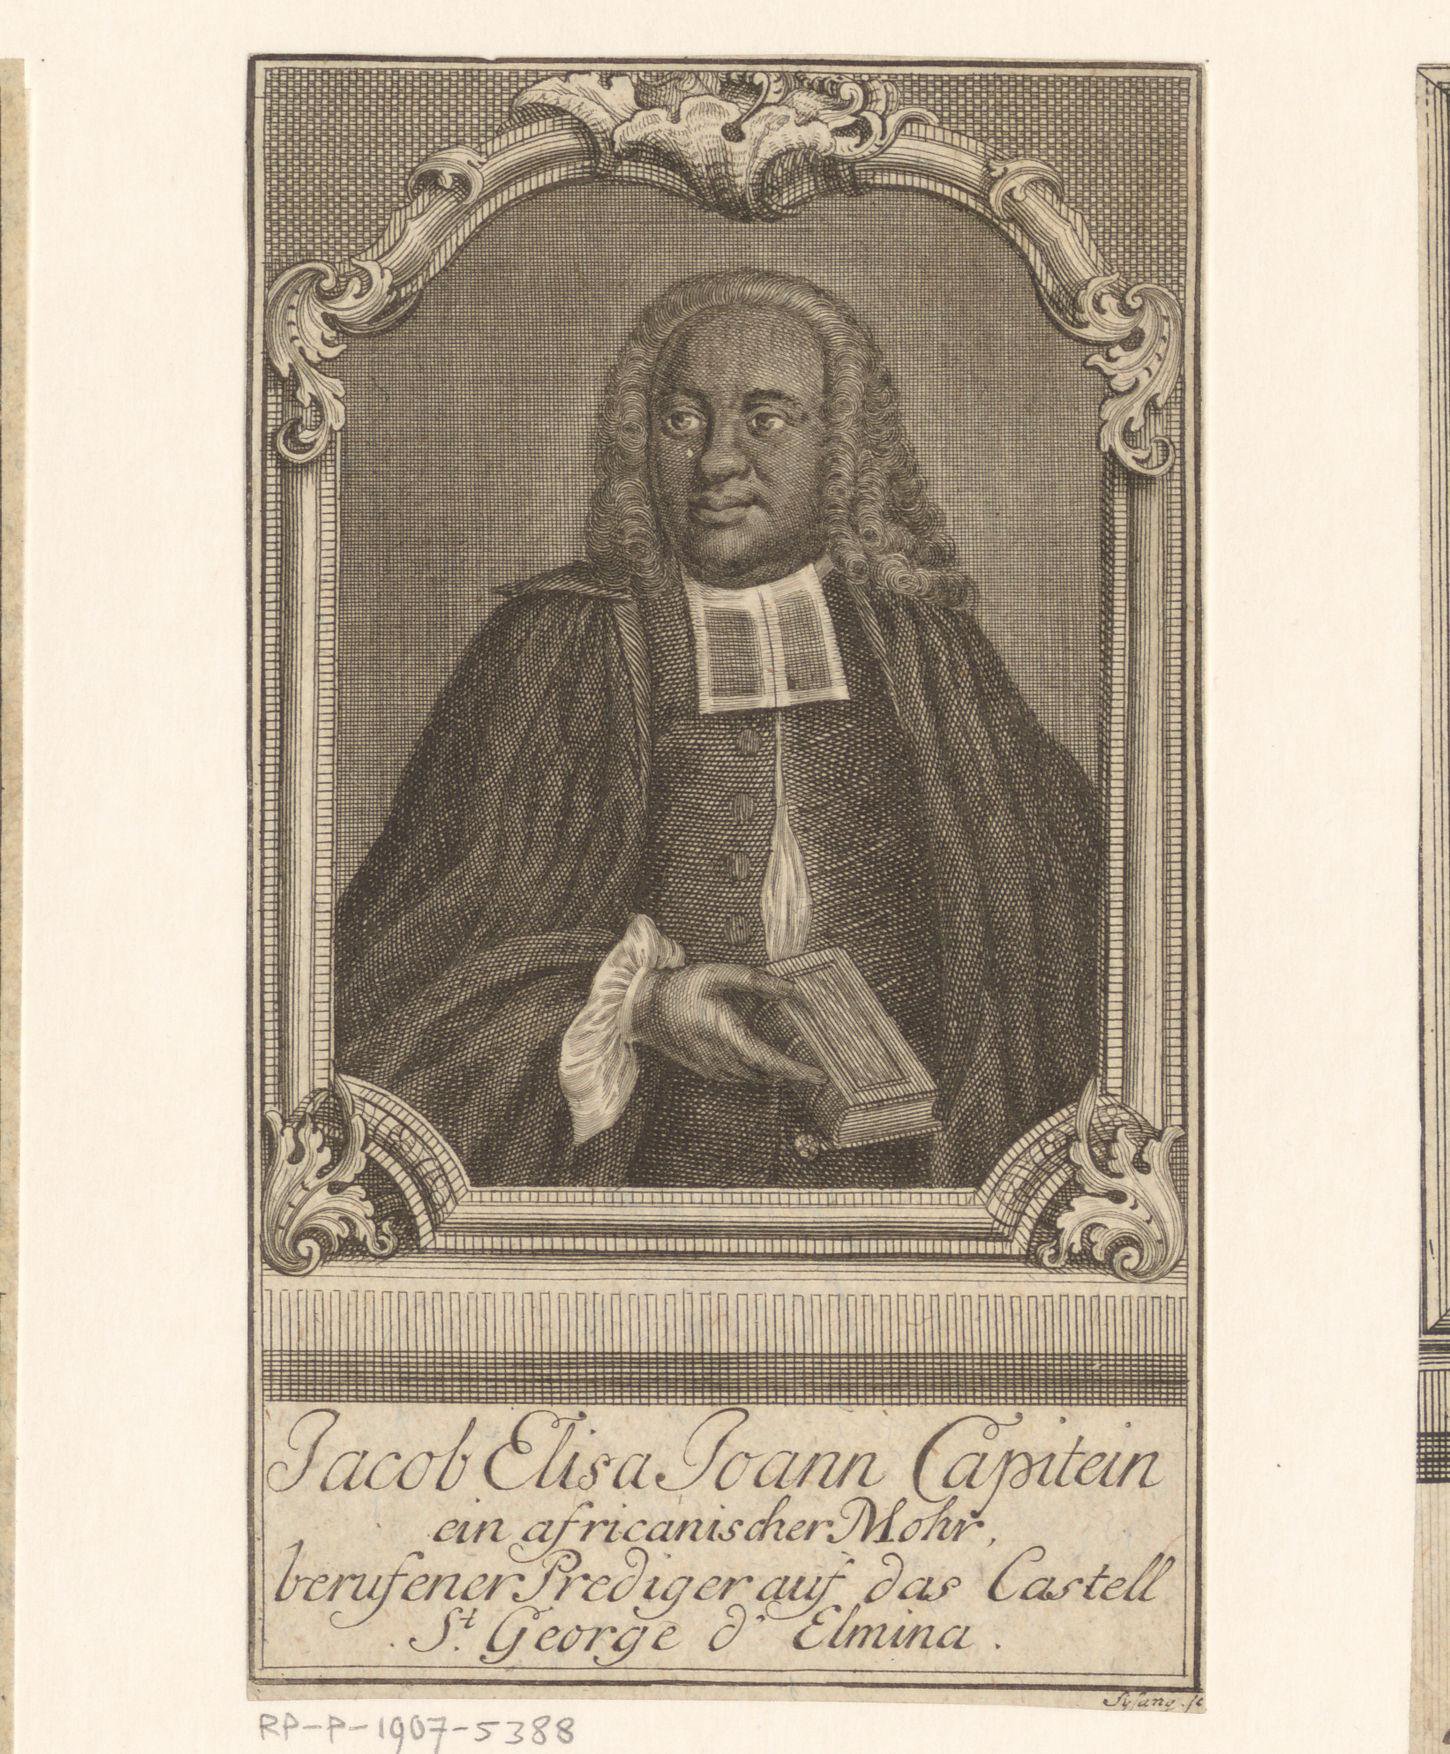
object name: print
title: Portret van predikant Jacobus Elisa Johannes Capitein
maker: johann christoph sysang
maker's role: print maker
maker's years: 1703-1757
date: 1742-1757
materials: paper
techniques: engraving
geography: germany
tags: jacobus elisa johannes capitein, africans, historical persons, functionaries and dignitaries ~ protestant churches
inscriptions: collector's mark: Lugt 2228